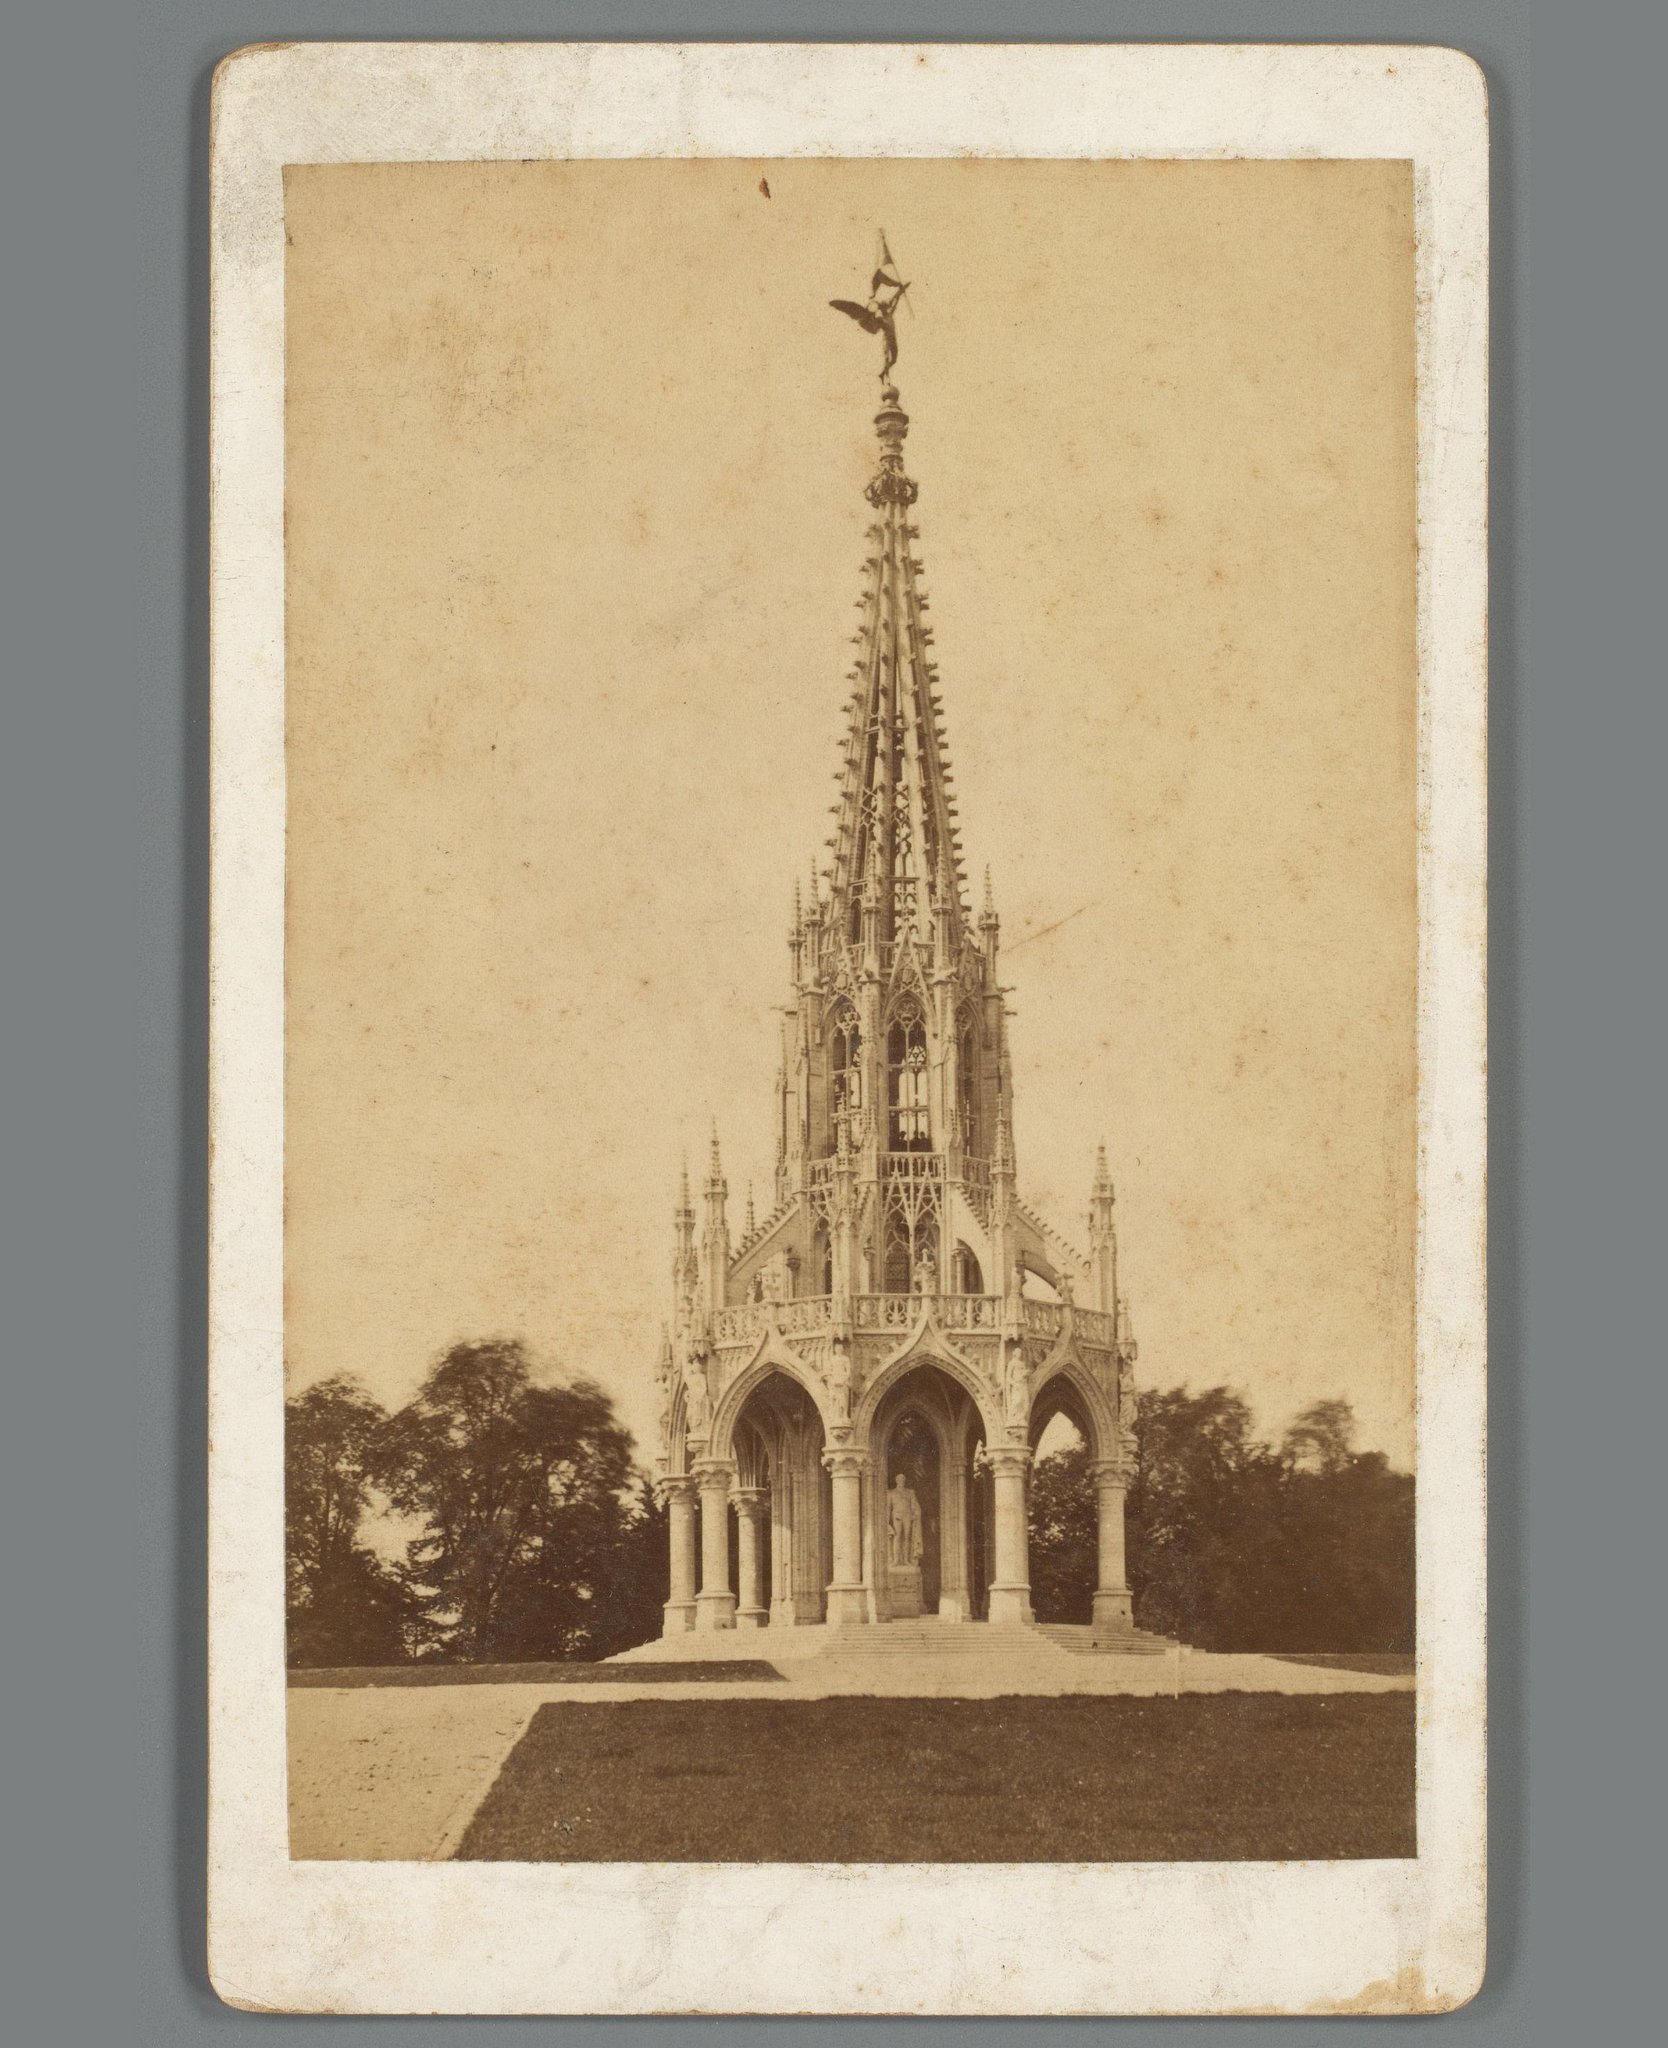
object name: cabinet photograph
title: Monument voor de Dynastie, Brussel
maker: Anonymous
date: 1881-1890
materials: cardboard, paper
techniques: albumen print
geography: brussels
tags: monument, statue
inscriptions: collector's mark: ‘Vosmaer’